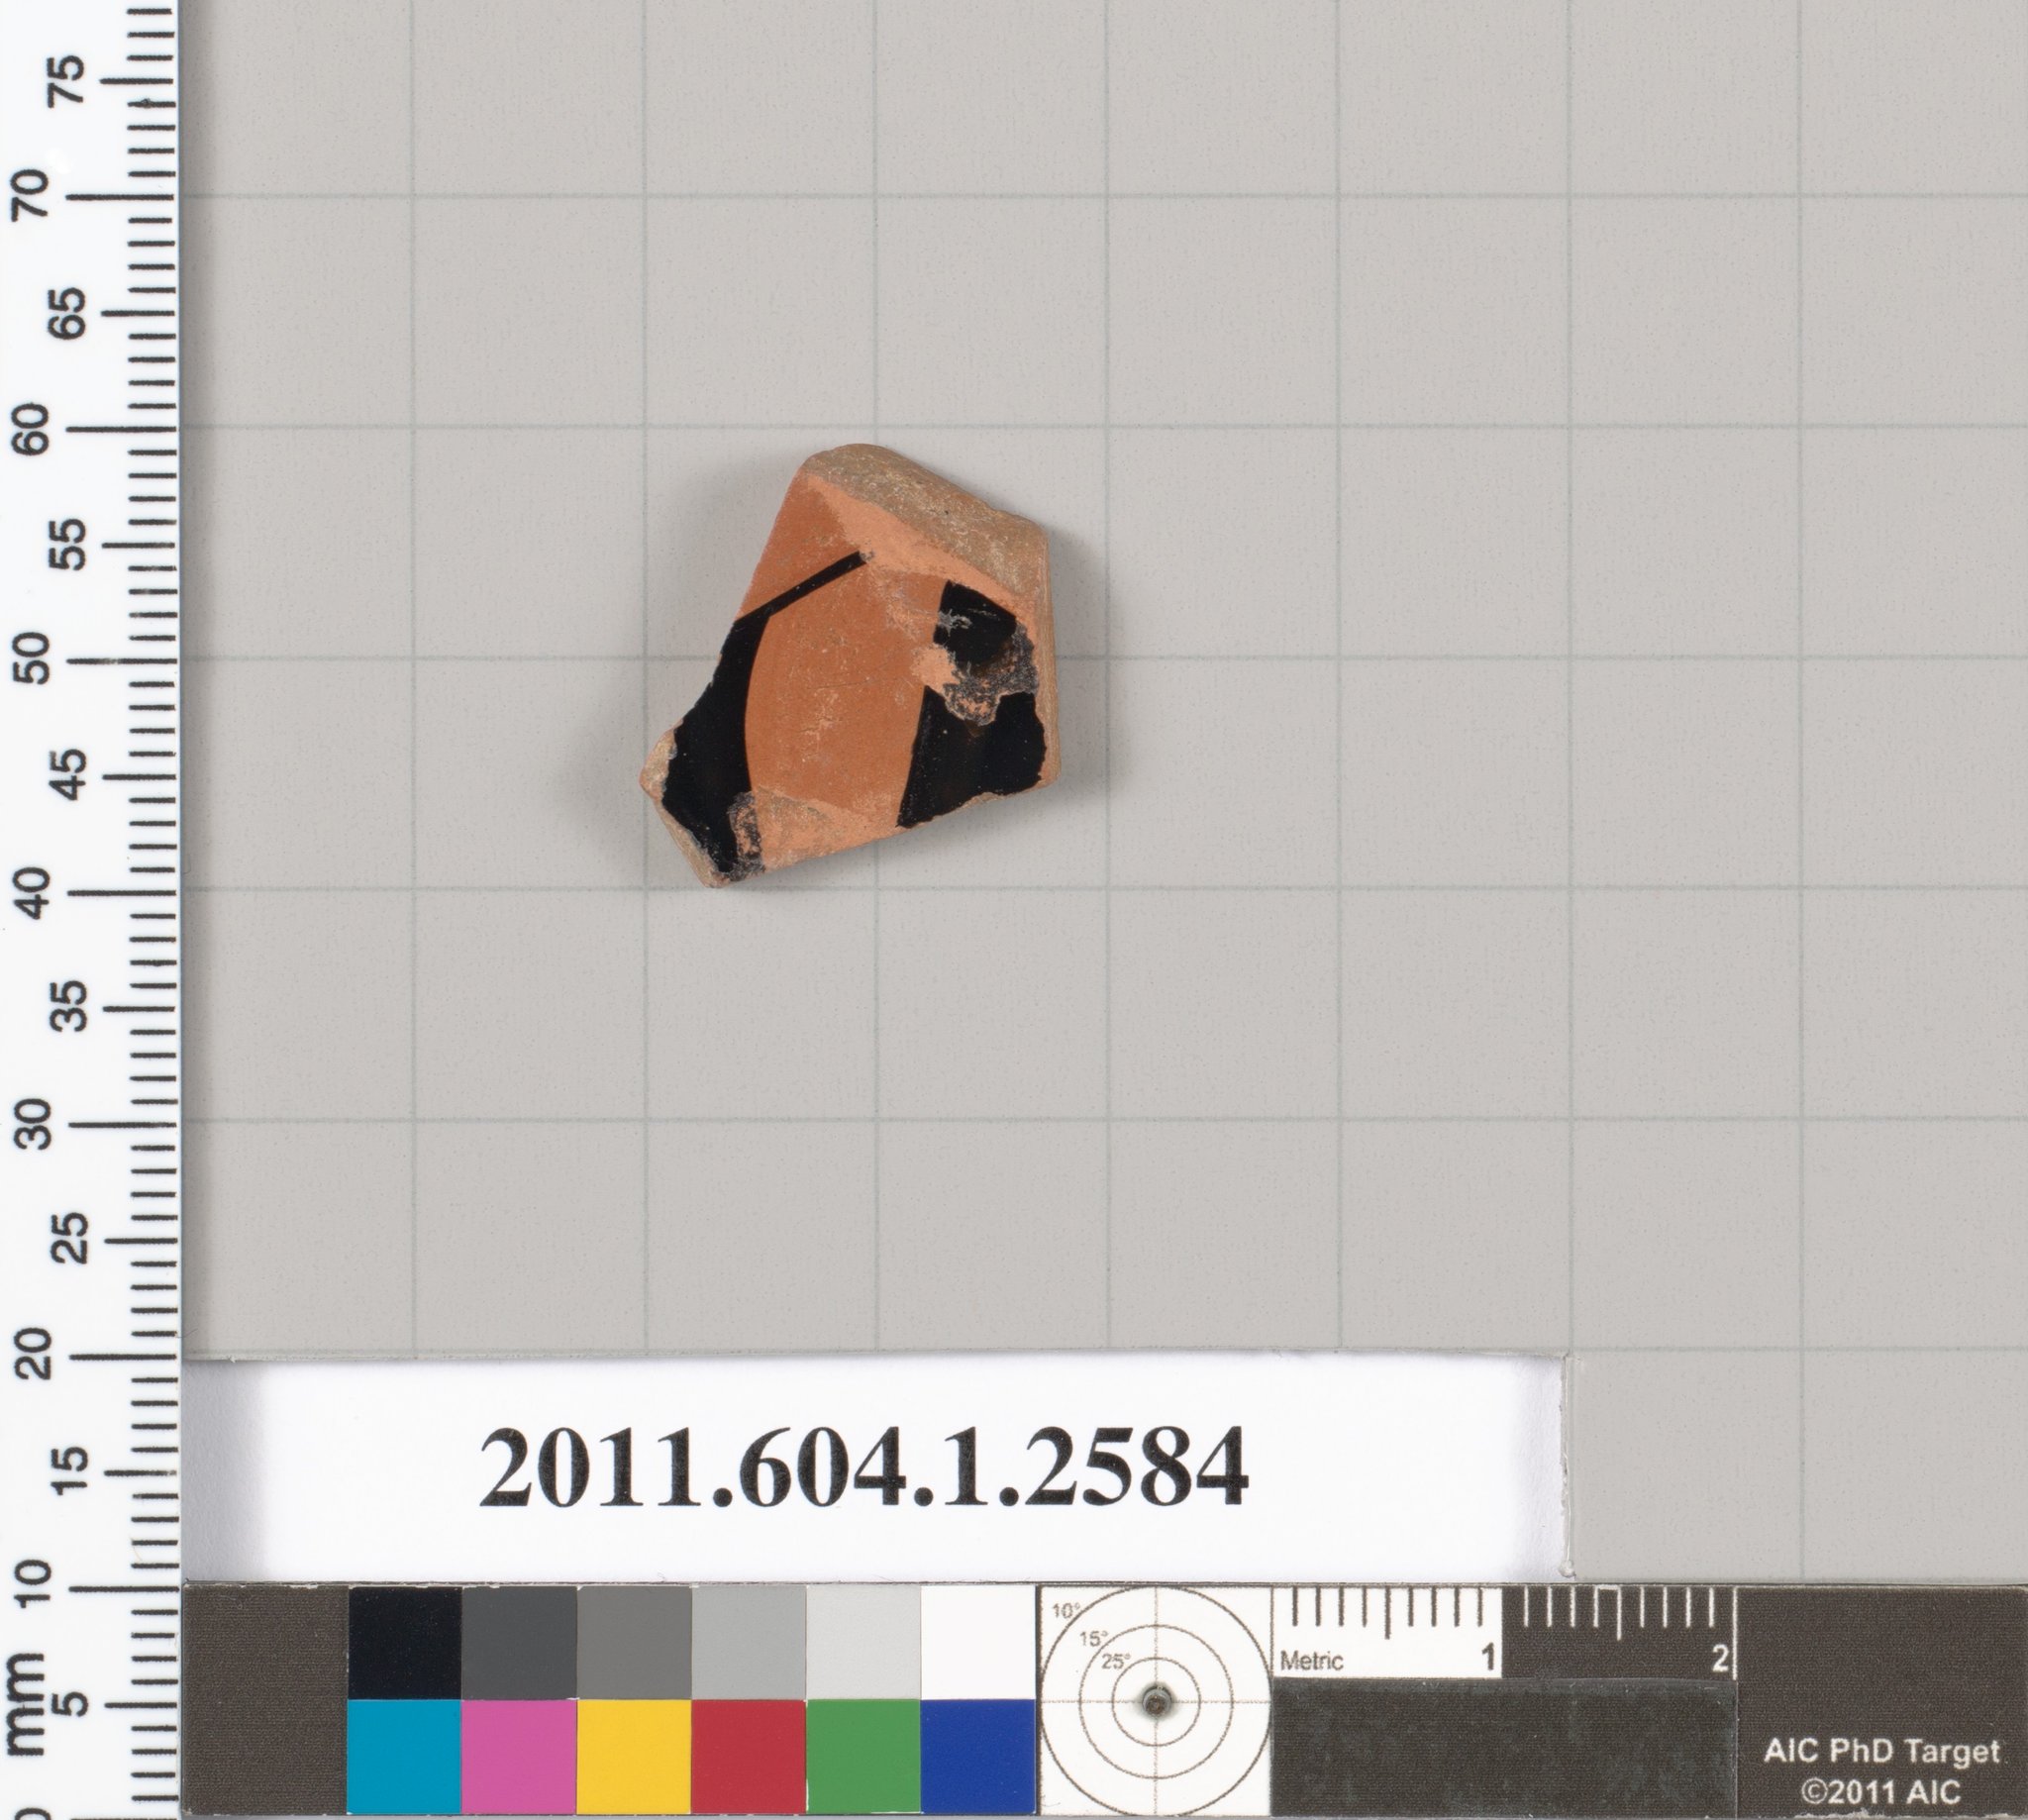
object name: kylix fragment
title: Terracotta fragment of a kylix (drinking cup)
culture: greek, attic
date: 490-480 BCE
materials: terracotta